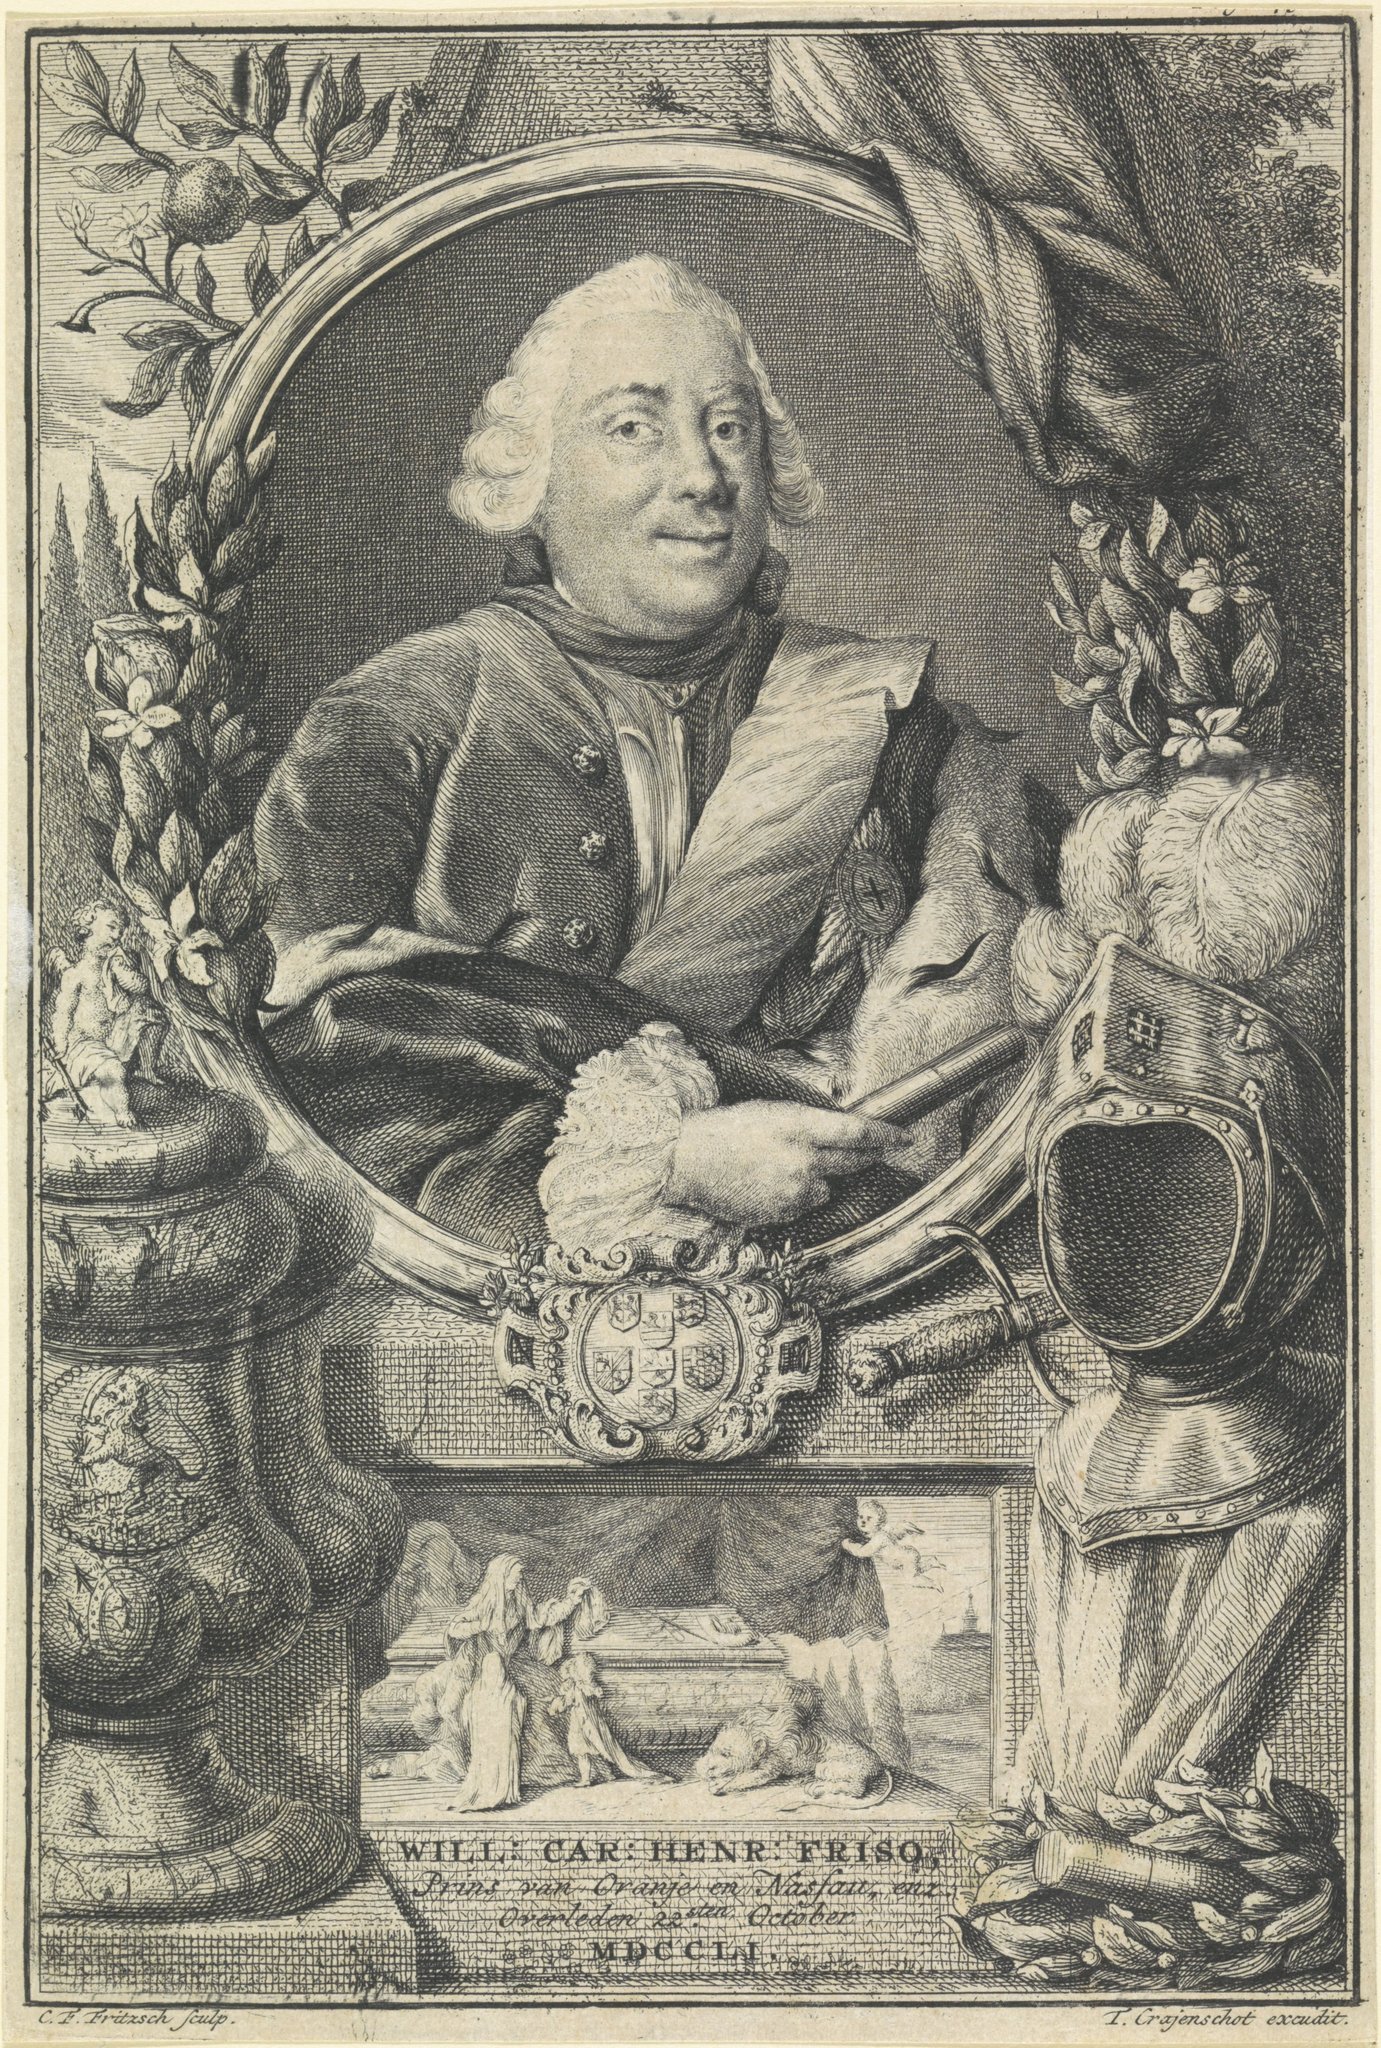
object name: book illustration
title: Portret van Willem IV, prins van Oranje-Nassau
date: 1751-1803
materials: paper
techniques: engraving, etching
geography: amsterdam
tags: willem iv (prins van oranje-nassau)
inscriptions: collector's mark: Lugt 2165, collector's mark: Lugt 963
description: Portret van Willem IV in een ovaal. In zijn rechterhand een commandostaf. Daar omheen een aantal allegorische objecten, waaronder een helm en oranjetakken. Op een voetstuk een voorstelling van zijn overlijden en vier regels Nederlandse tekst. Rechtsboven 'Pag: 49.'.